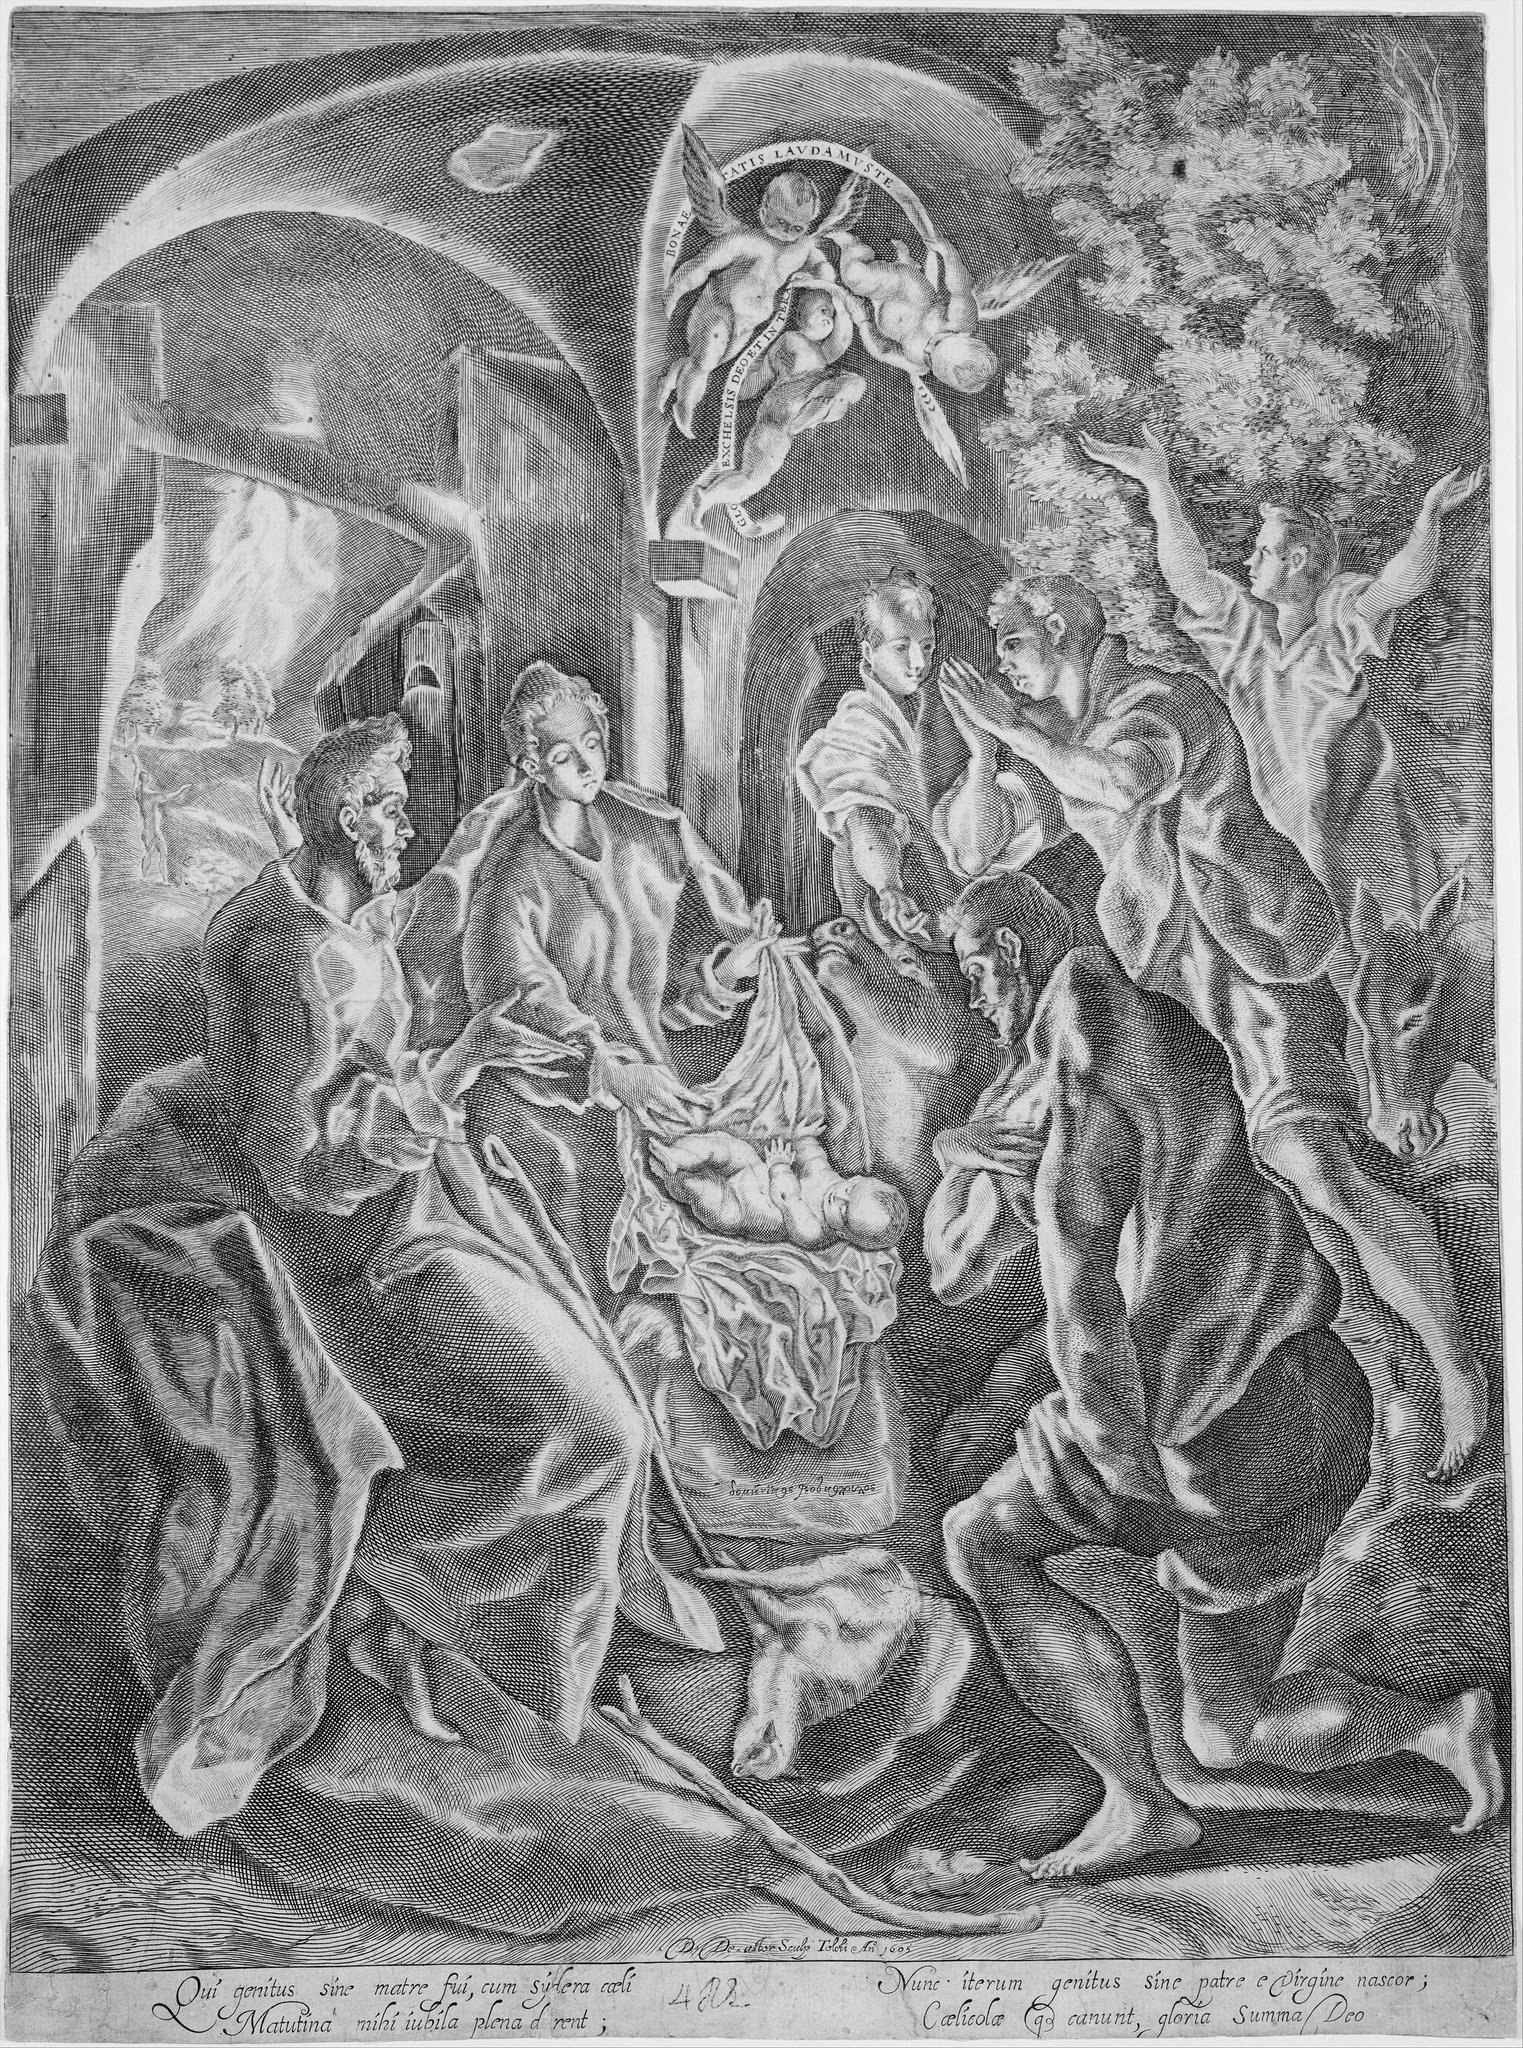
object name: print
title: The adoration of the shepherds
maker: diego de astor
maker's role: artist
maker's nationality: spanish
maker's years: 1580-1620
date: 1605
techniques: engraving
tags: men,angels,adoration of the shepherds